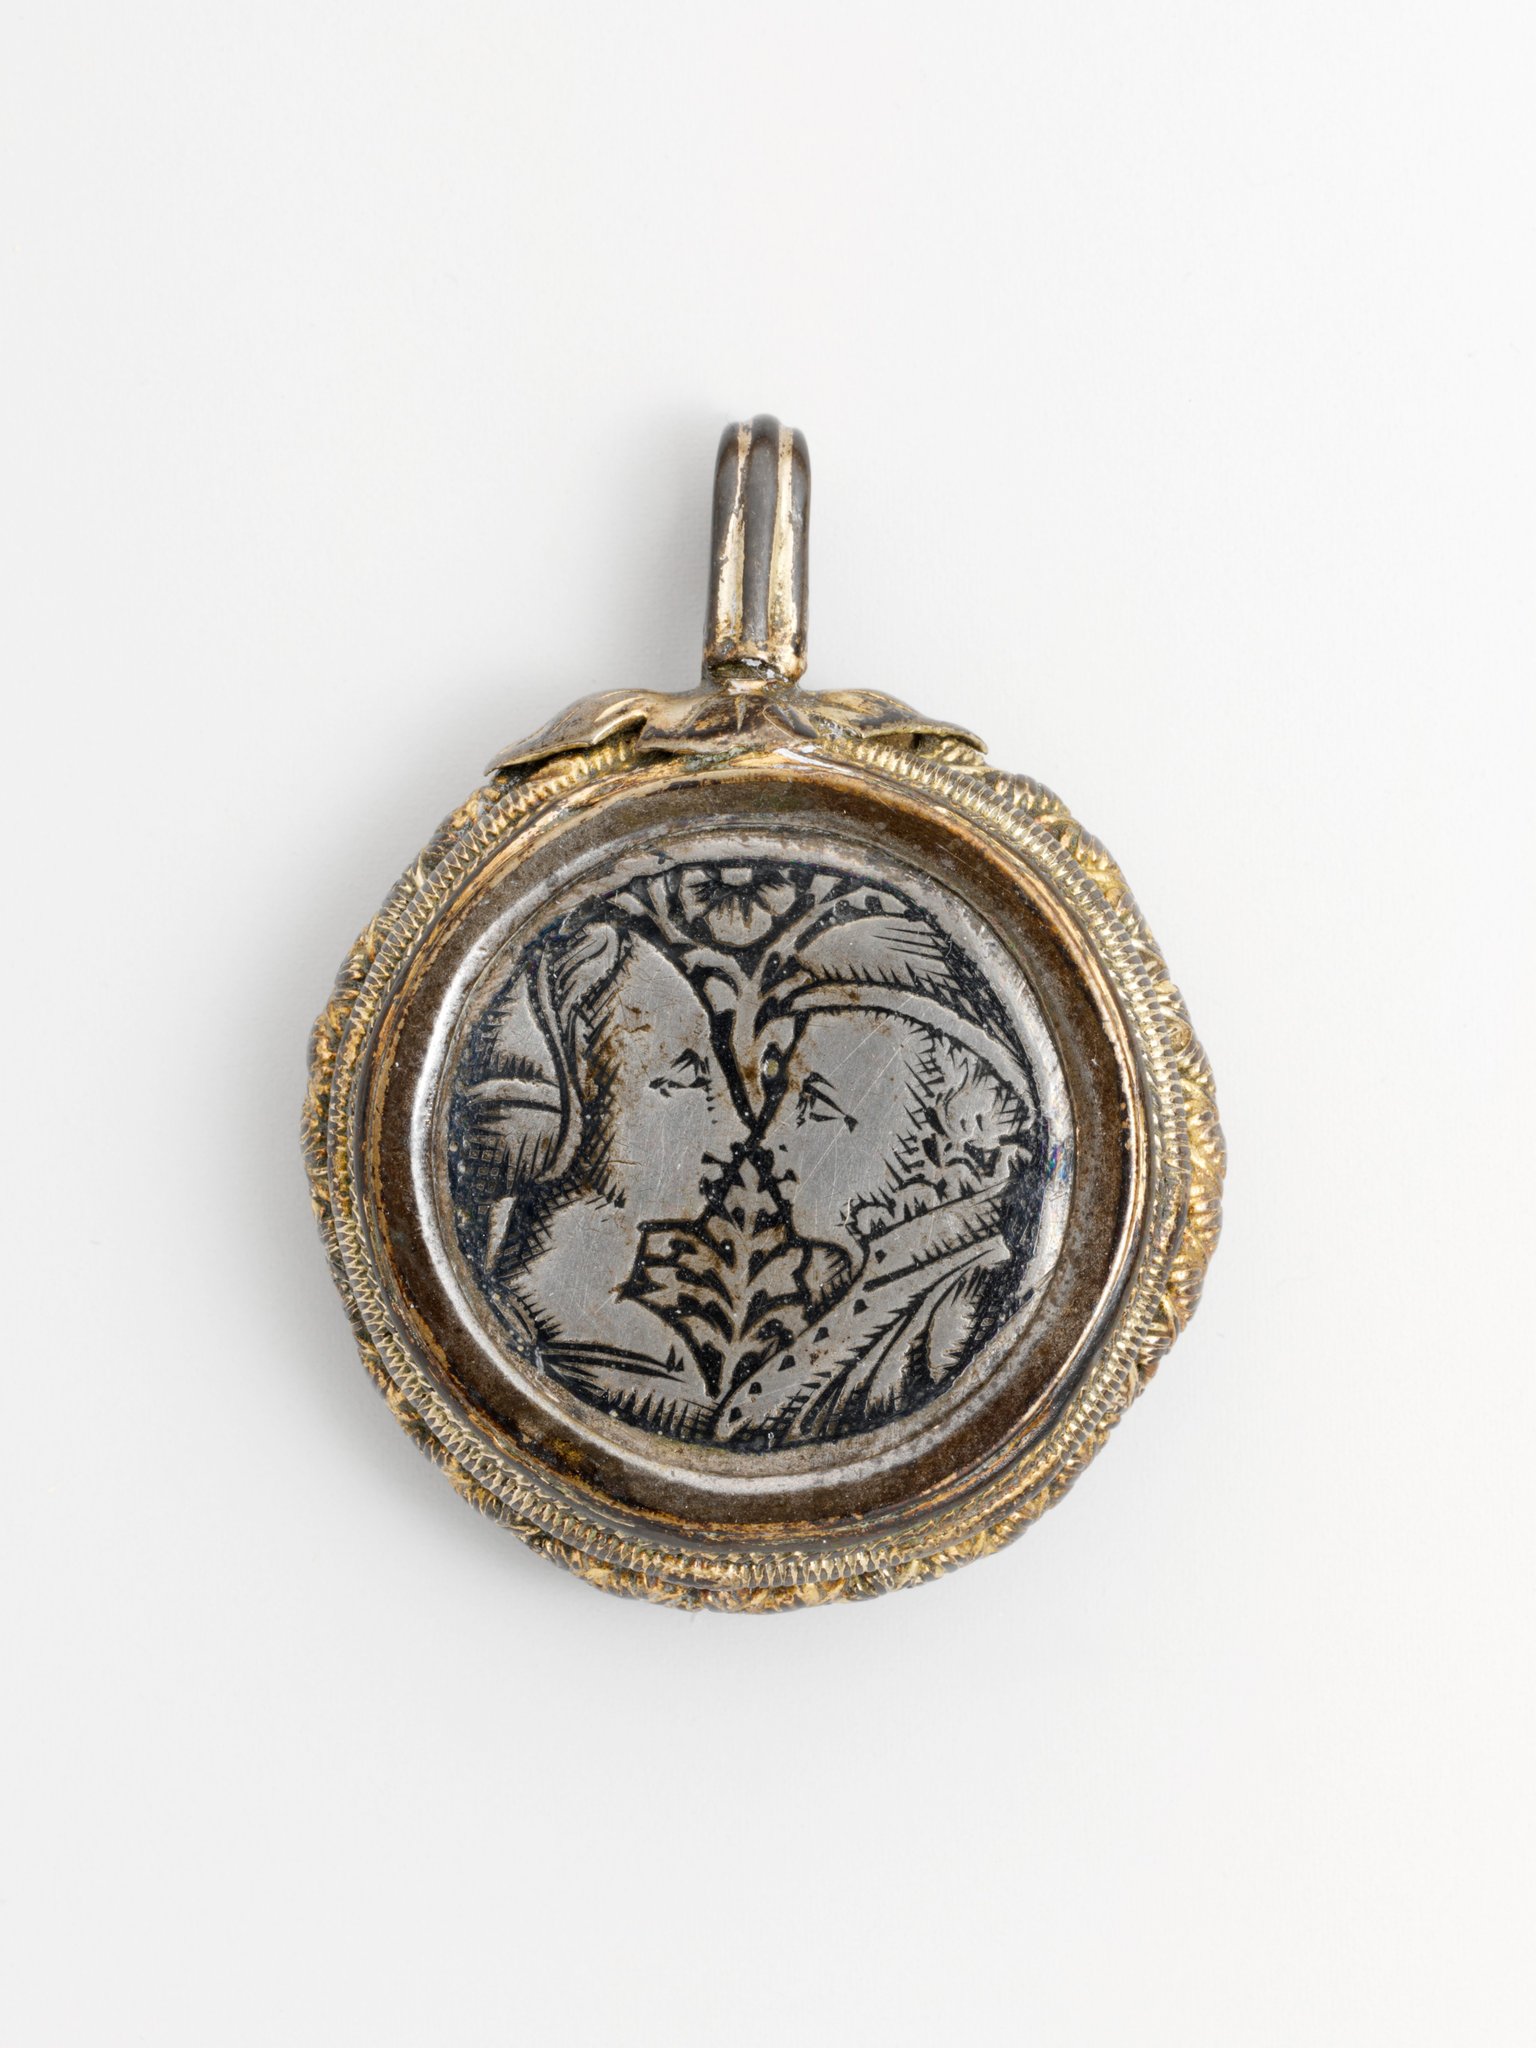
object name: pendant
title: Pendant (one of a pair)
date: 1451-1500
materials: silver gilt, niello, silver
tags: men,women